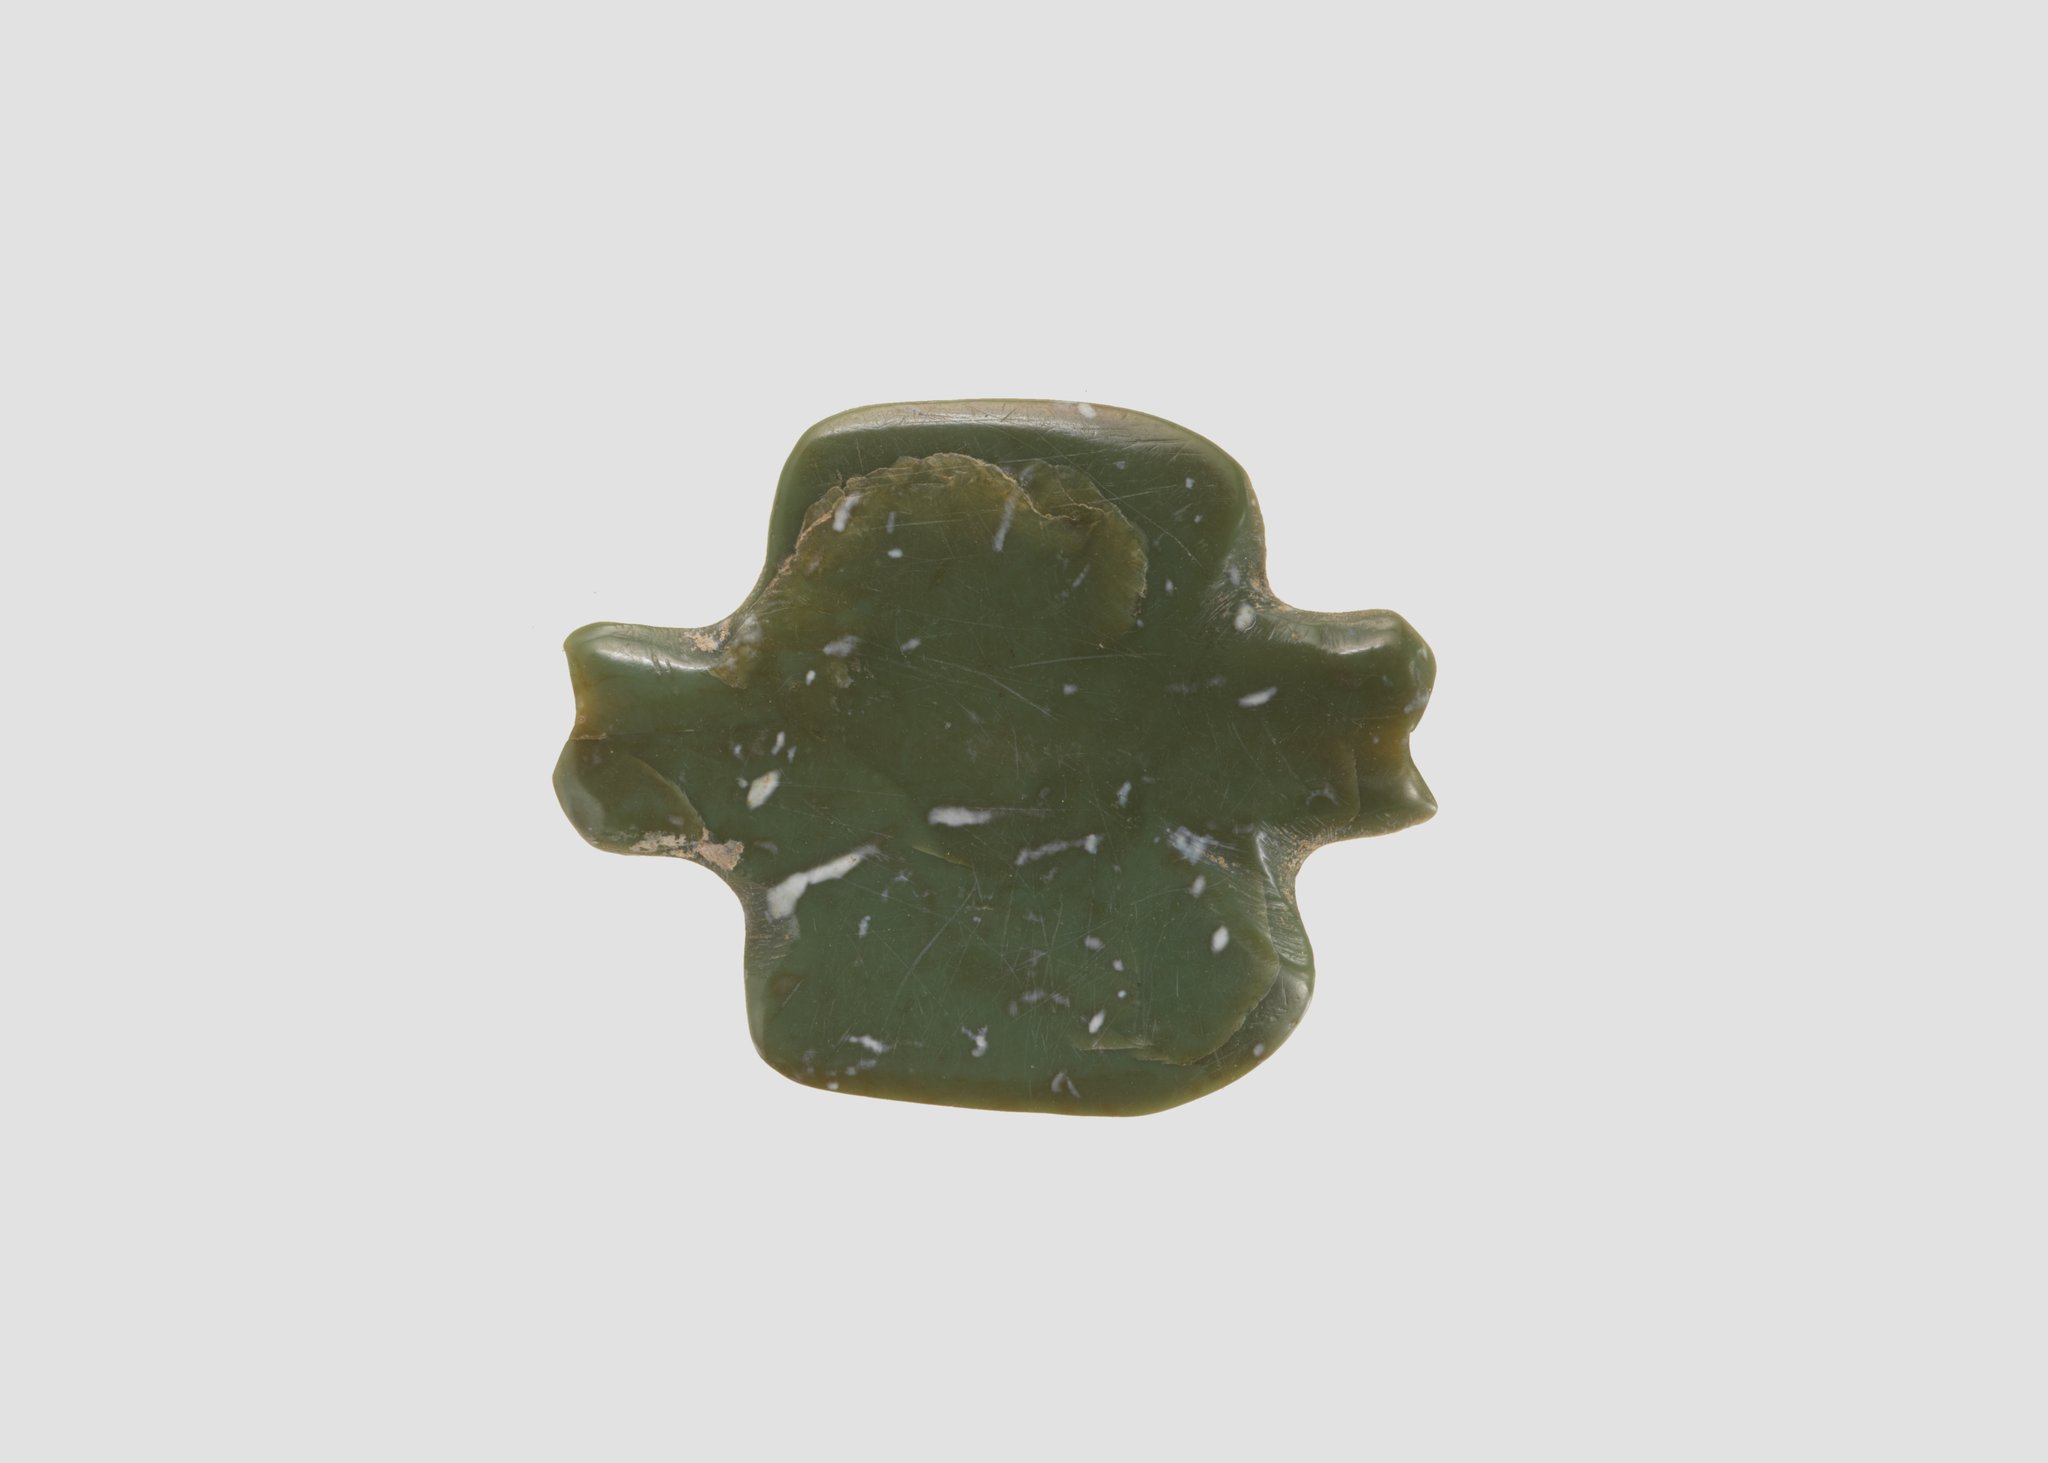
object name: bead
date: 7333-7001 BCE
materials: stone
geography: syria